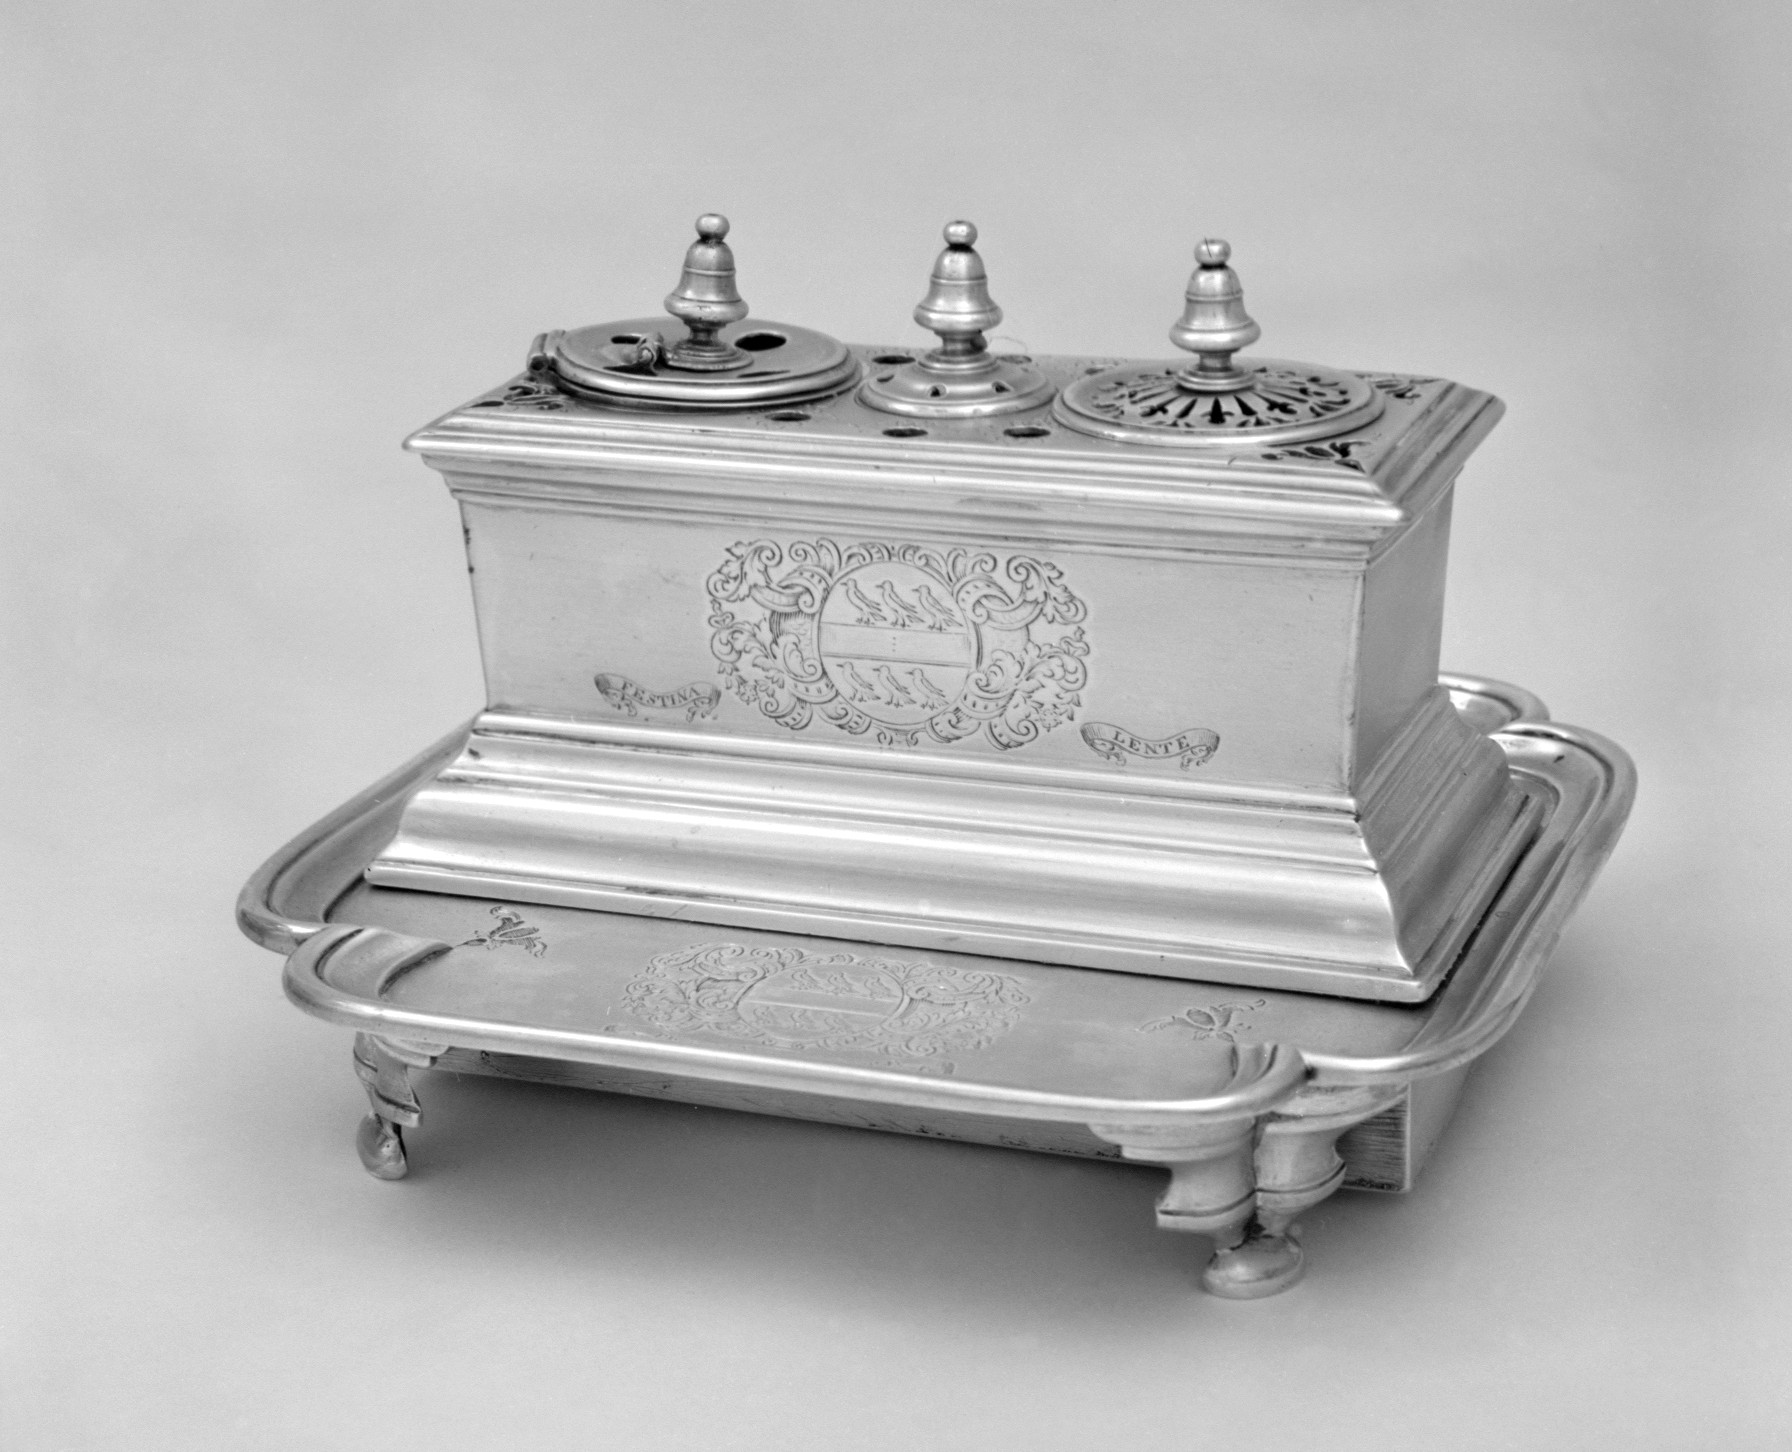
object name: inkstand on tray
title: Inkstand on a tray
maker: samuel lee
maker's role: maker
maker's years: 1675-1775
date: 1726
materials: silver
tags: coat of arms